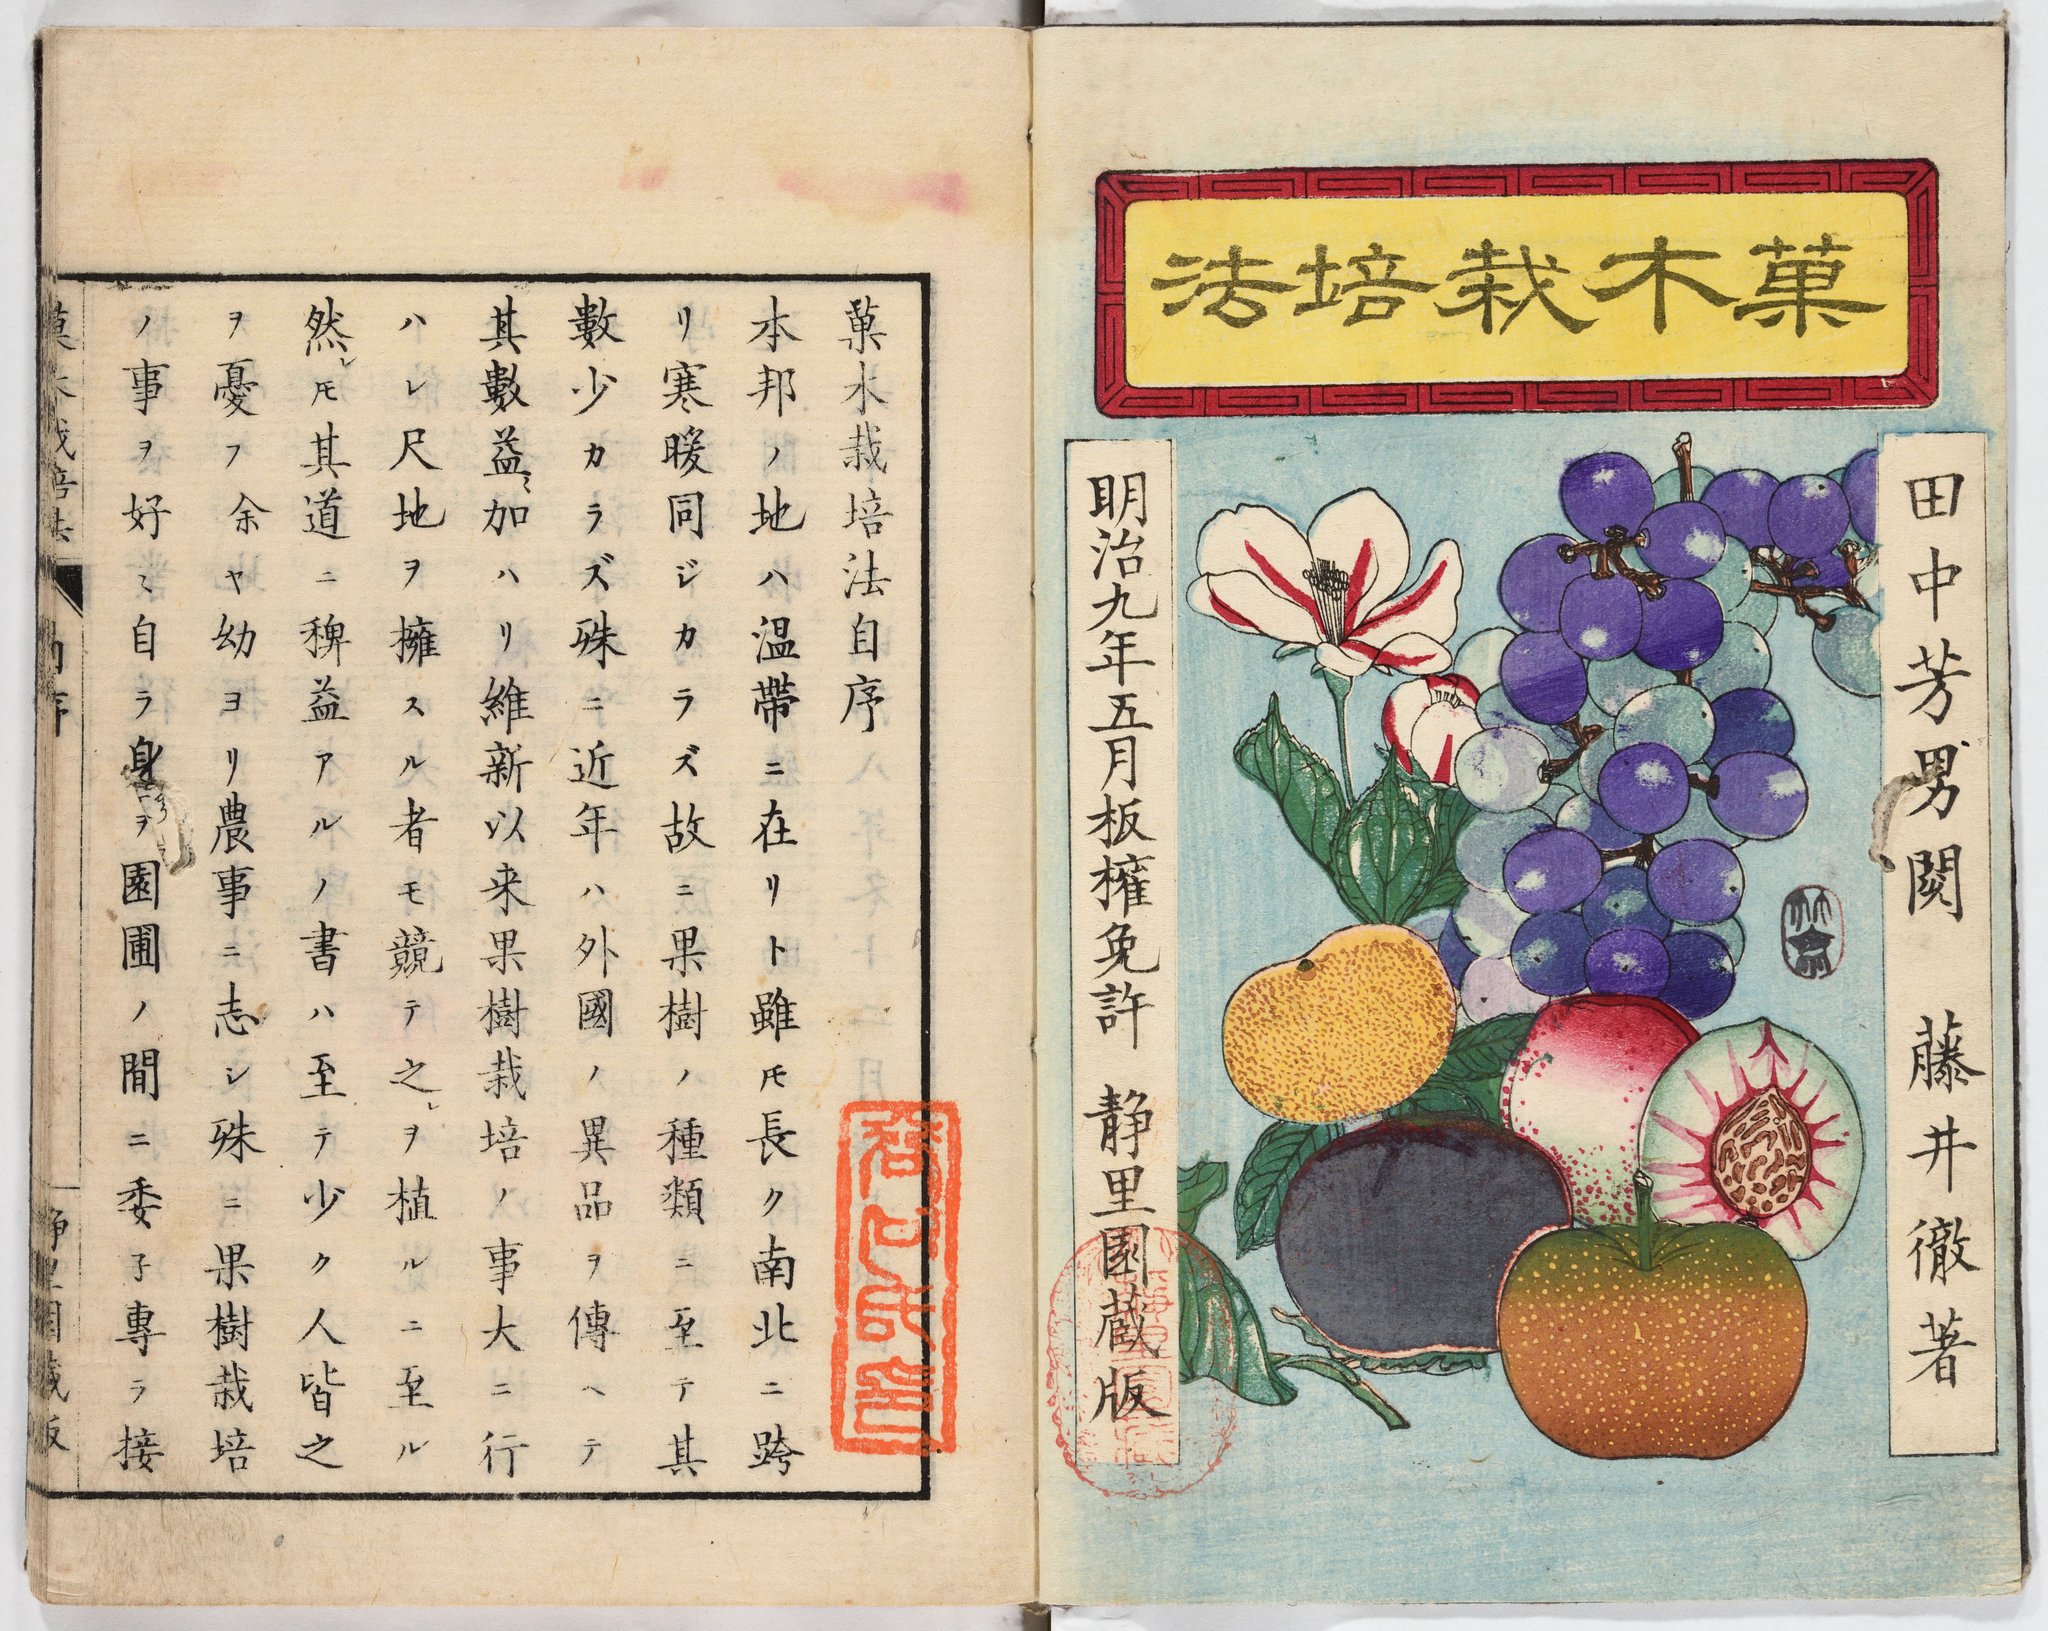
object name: illustrated book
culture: japanese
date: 1893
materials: ink, paper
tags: fruit,flowers